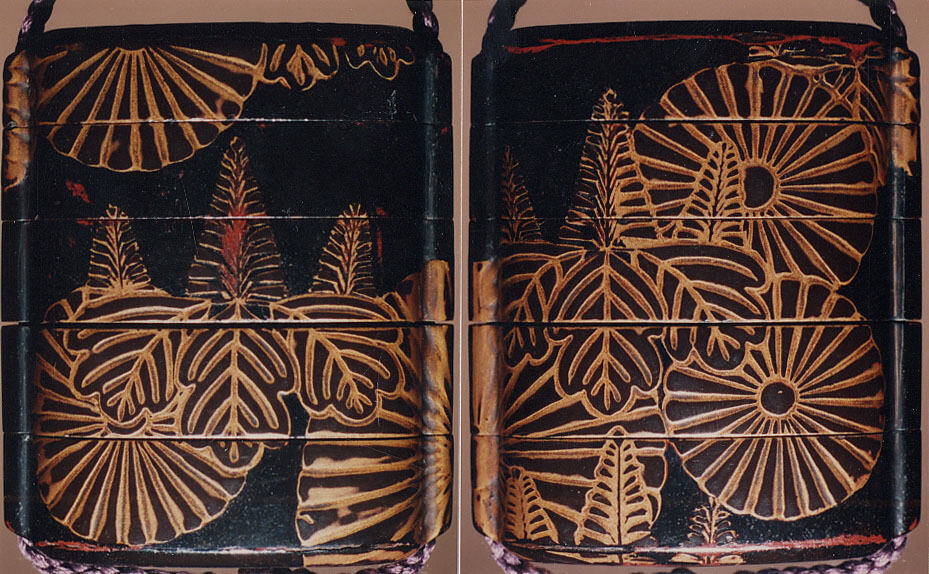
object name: inrō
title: Case (Inrō) with Design of Chrysanthemum and Pawlonia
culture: japanese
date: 1701-1800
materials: gold, lacquer, metal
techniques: fundame, hiramakie, inlay, roiro, maki-e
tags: flowers